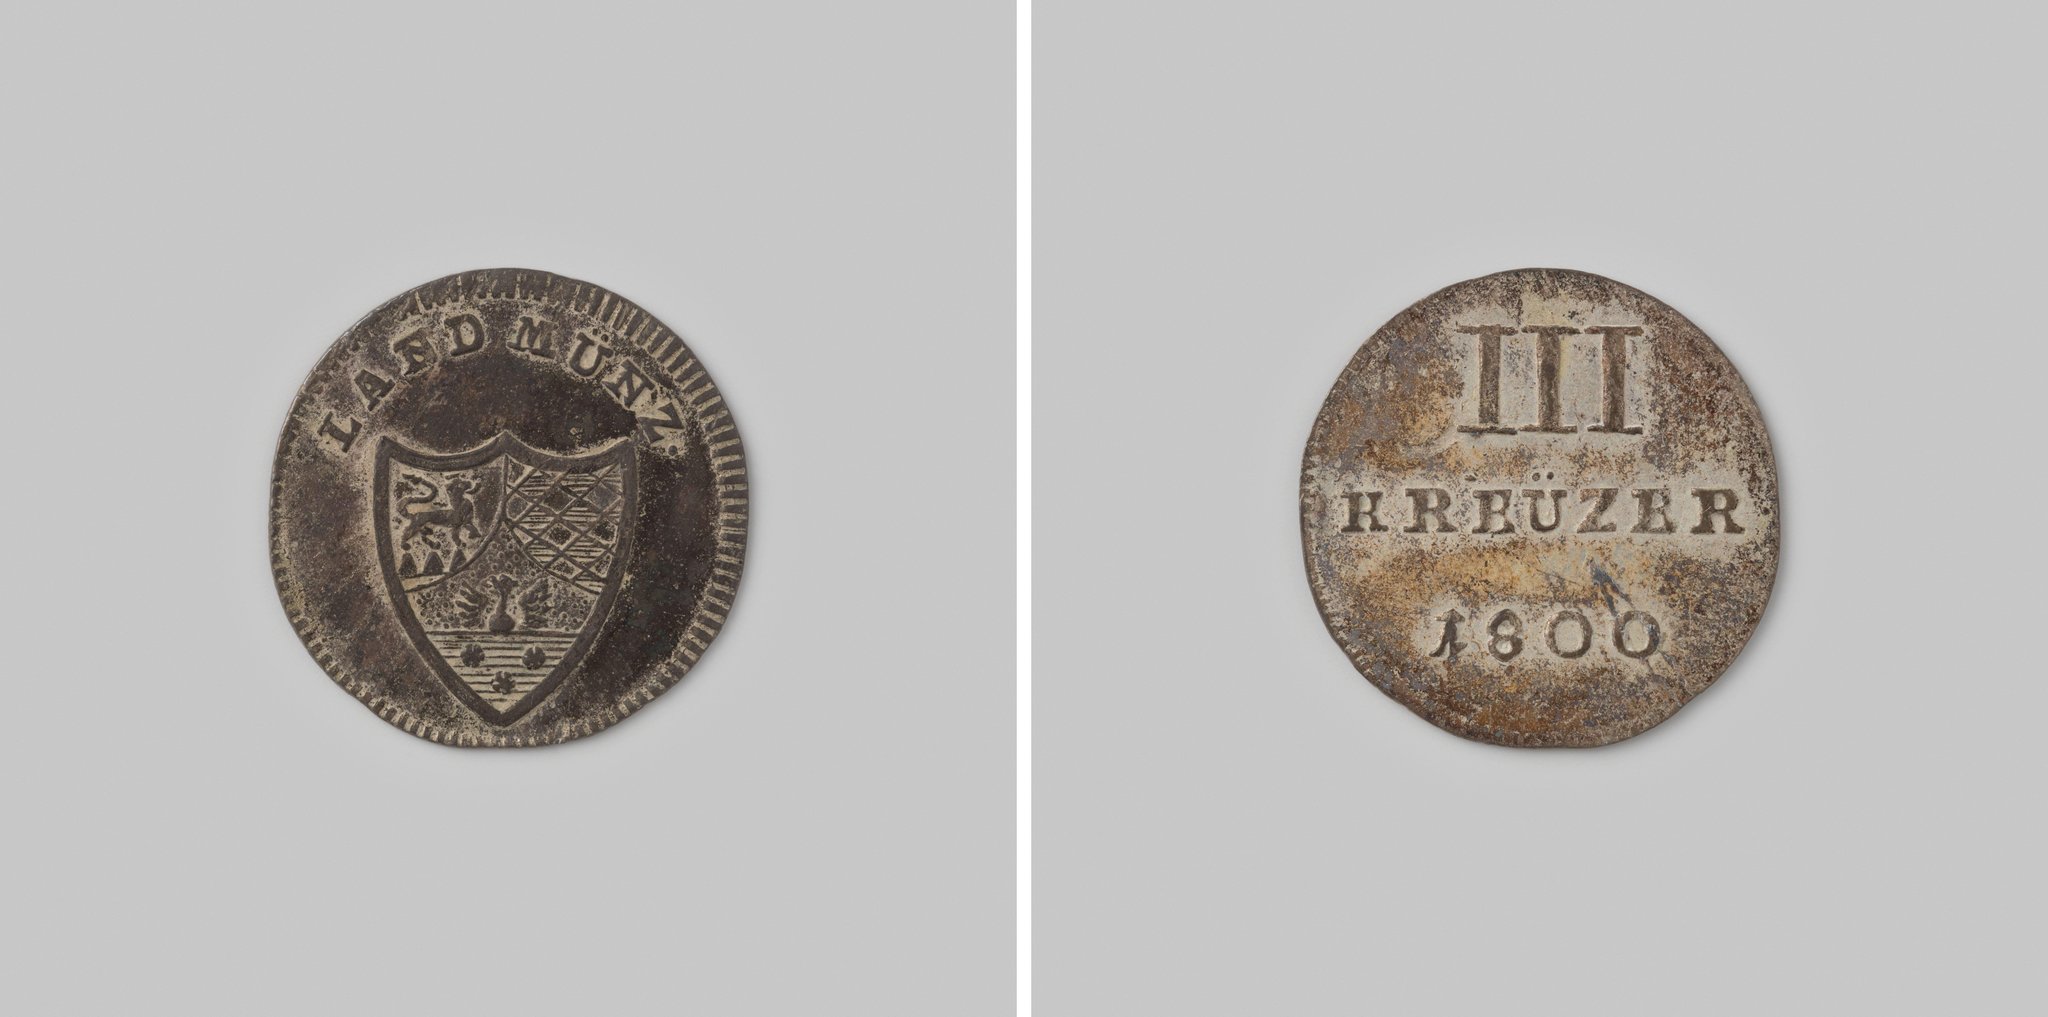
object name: coin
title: Vorstendom Löwenstein-Wertheim-Rochefort, Dominicus-Konstantin, 3 kreuzer, 1800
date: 1800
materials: silver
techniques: striking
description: Zilveren munt. Voorzijde: wapenschild. Keerzijde: waarde-aanduiding in twee regels, waaronder jaartal. Gladde rand.